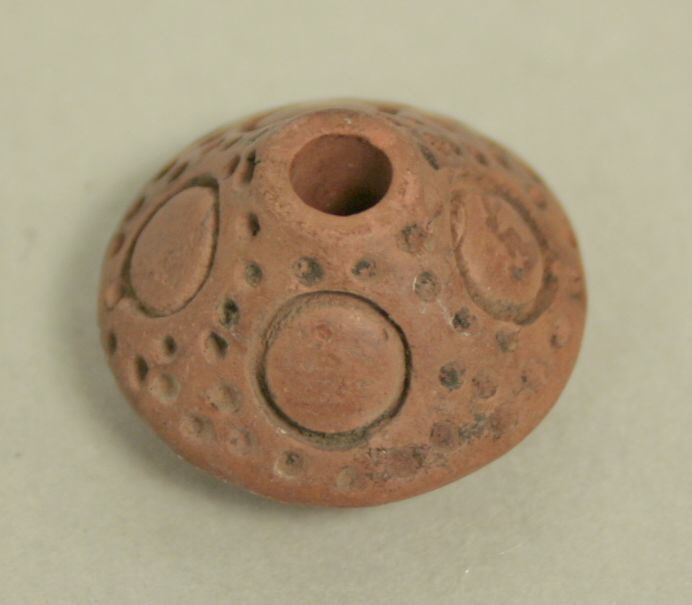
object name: spindle whorl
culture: peruvian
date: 1-500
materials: ceramic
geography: peru